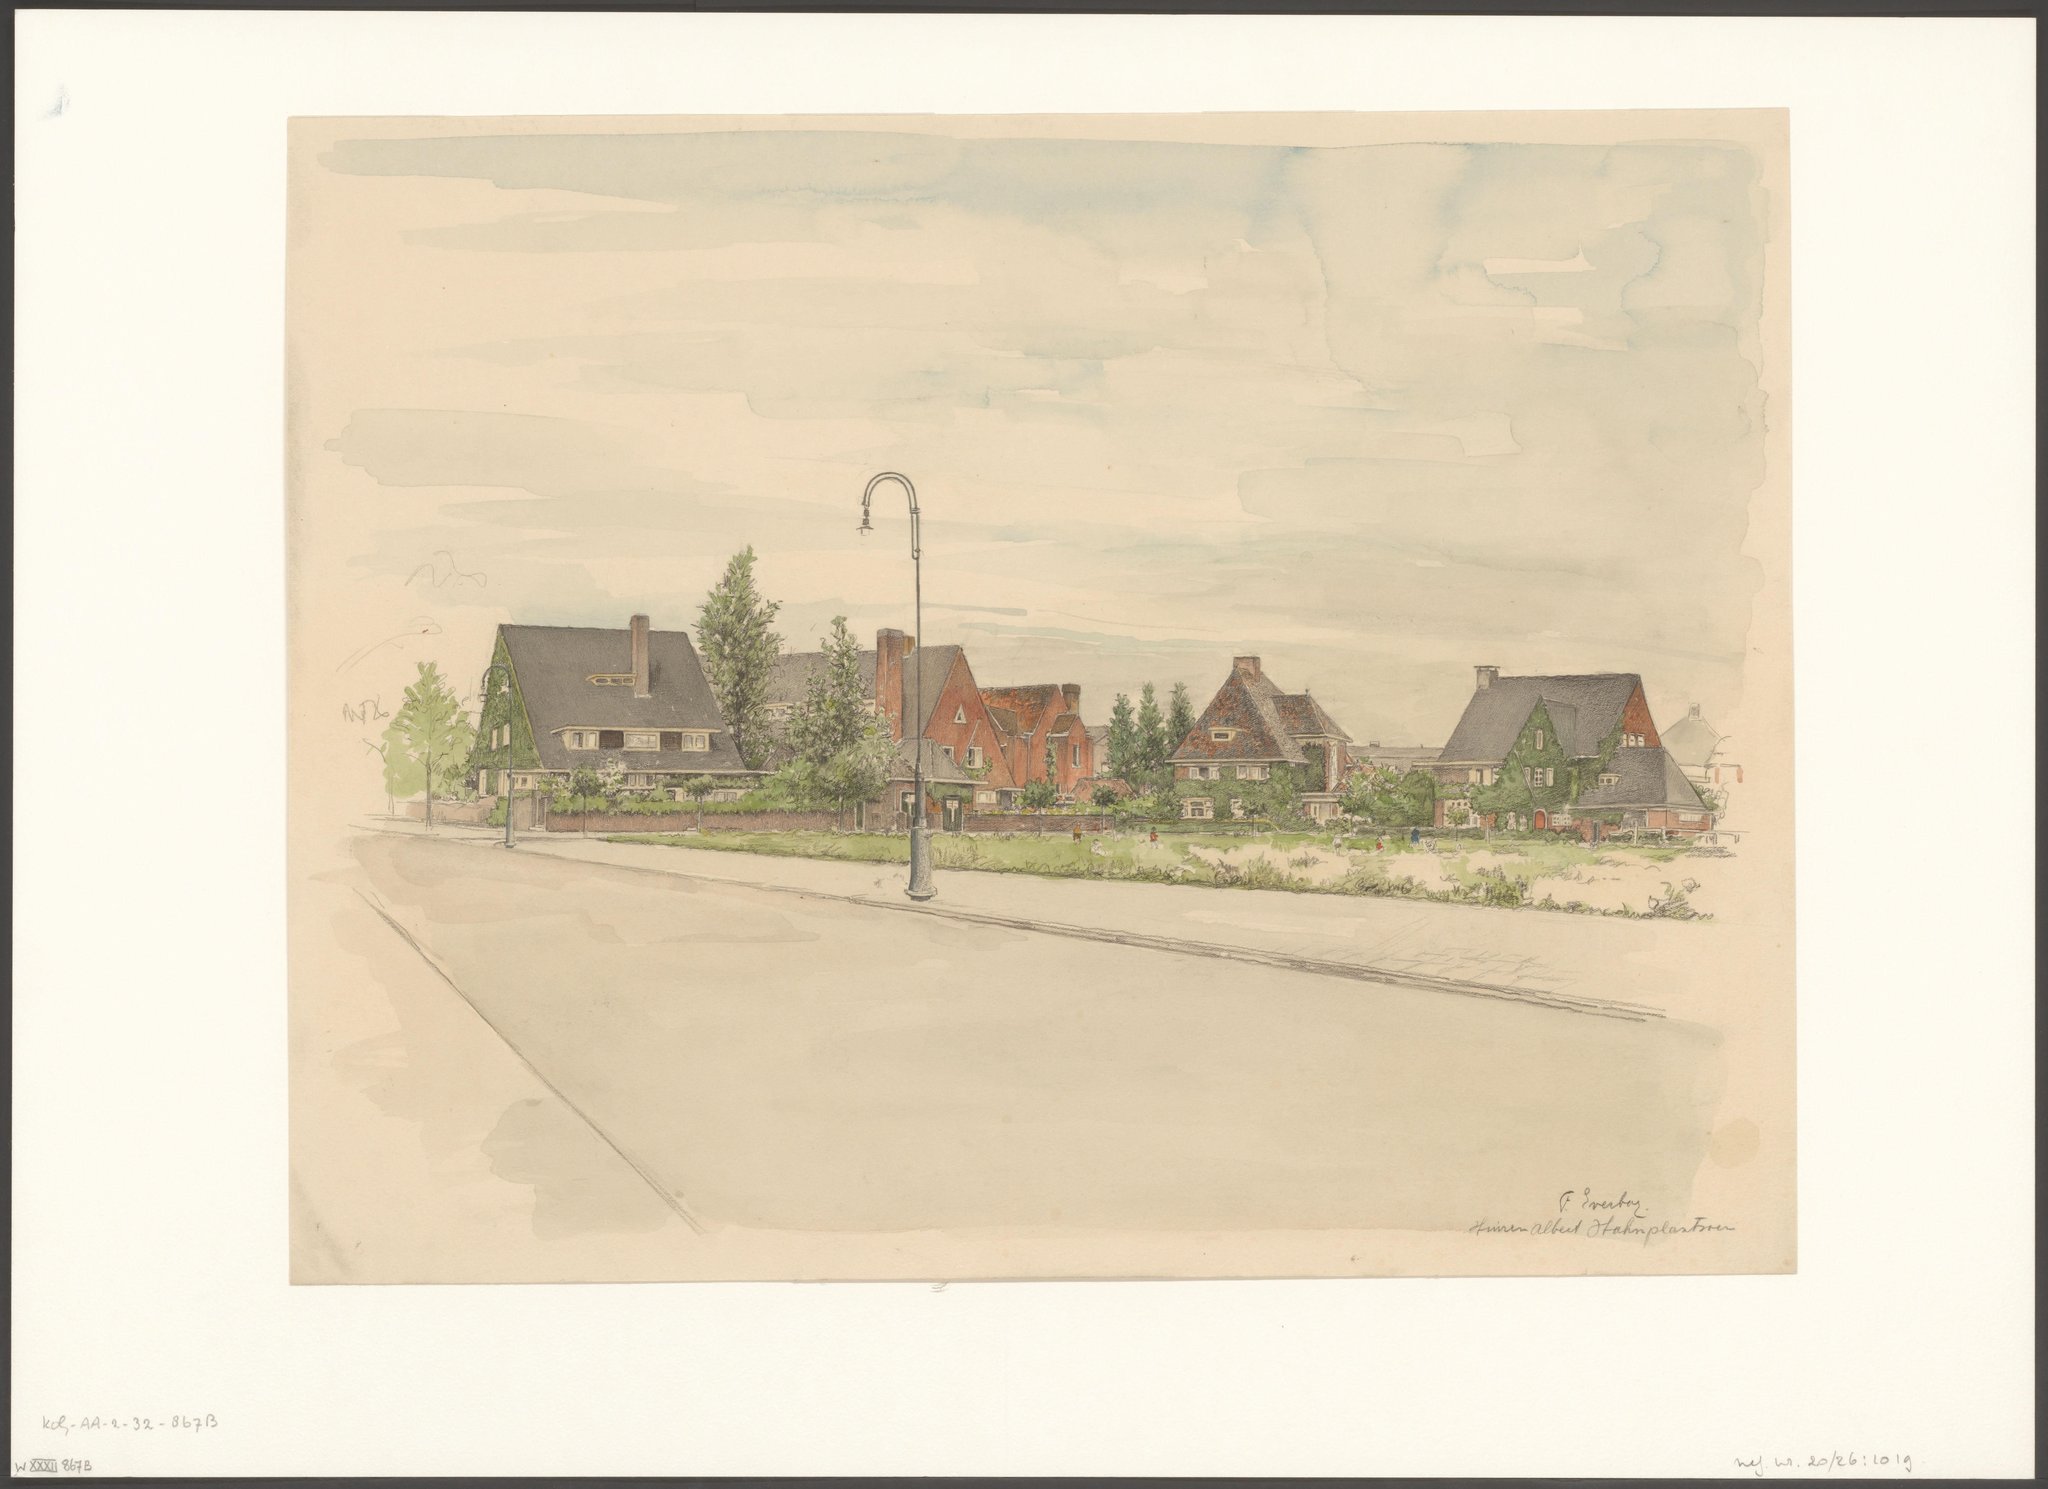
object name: drawing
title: Gezicht op het Albert Hahnplantsoen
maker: frans everbag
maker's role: draughtsman, print maker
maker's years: 1877-1947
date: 1887-1947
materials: chalk, gouache, paper, pencil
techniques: brush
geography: amsterdam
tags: city-view in general; 'veduta', the usual house or row of houses, street, public gardens, park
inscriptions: collector's mark: Lugt 800a, inscription: ‘Huizen Albert Hahnplantsoen’, signature: ‘F. Everbag’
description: Tekening binnen de Atlas Van Eck ingedeeld op wijknummer 32.